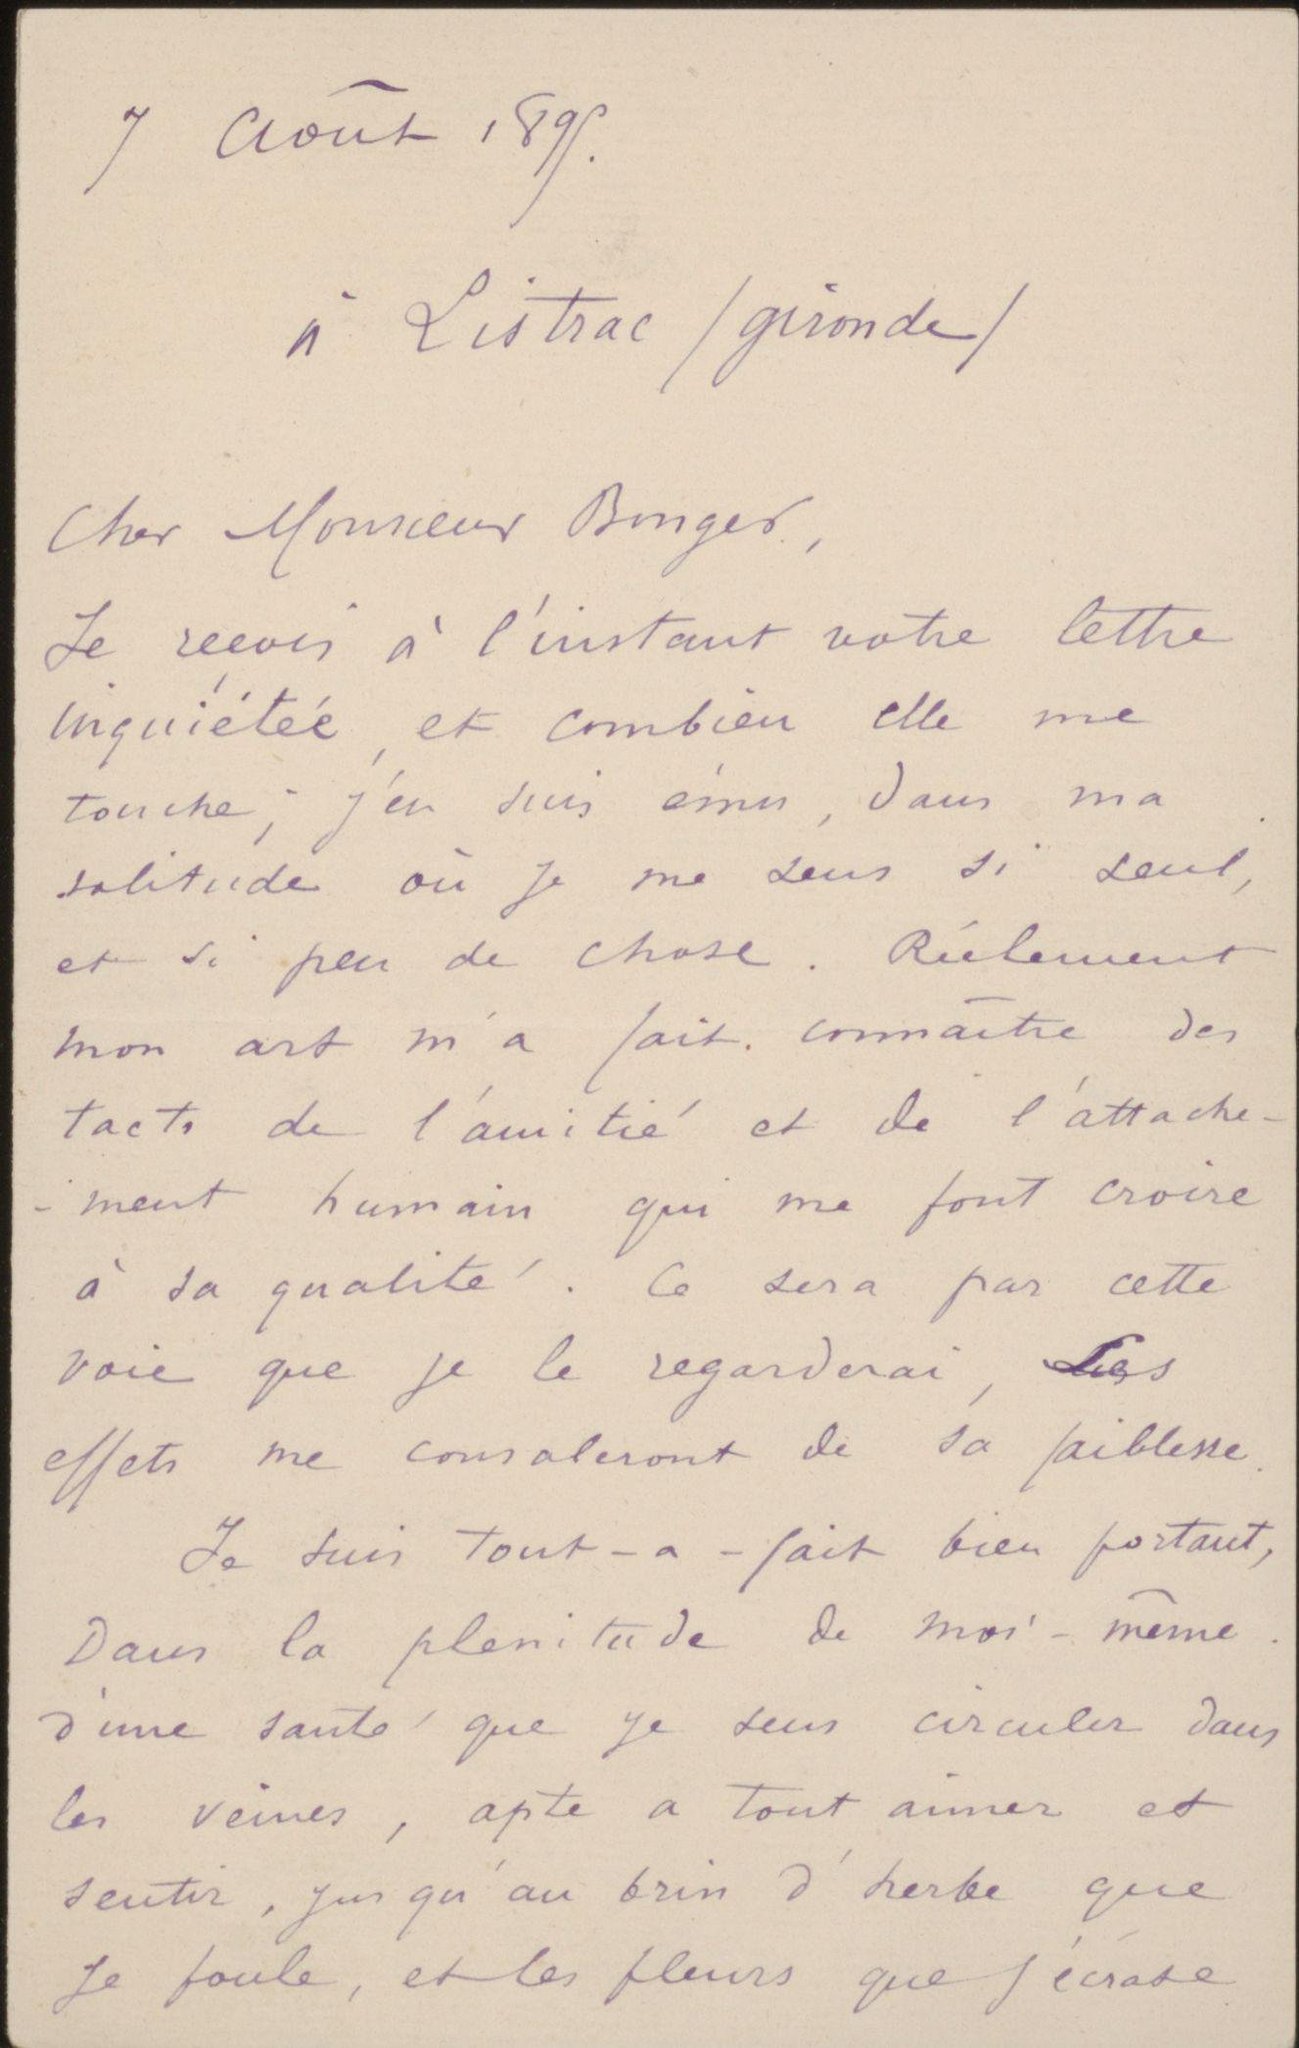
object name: letter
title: Brief aan Andries Bonger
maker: odilon redon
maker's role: draughtsman, painter, print maker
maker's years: 1840-1916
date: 1895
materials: ink, paper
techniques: pen, writing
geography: listrac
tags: rafaël, lille, émile bernard, leiden, rembrandt van rijn, printer, publisher, rome, michelangelo, andries bonger, arnhem, anacapri, sculptor, saar de swart, artist, leonardo da vinci, passions, emotions, affections, music, photography, cinematography, family life, exhibition ~ art, diseases, italy, the hague, london, paris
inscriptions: watermark